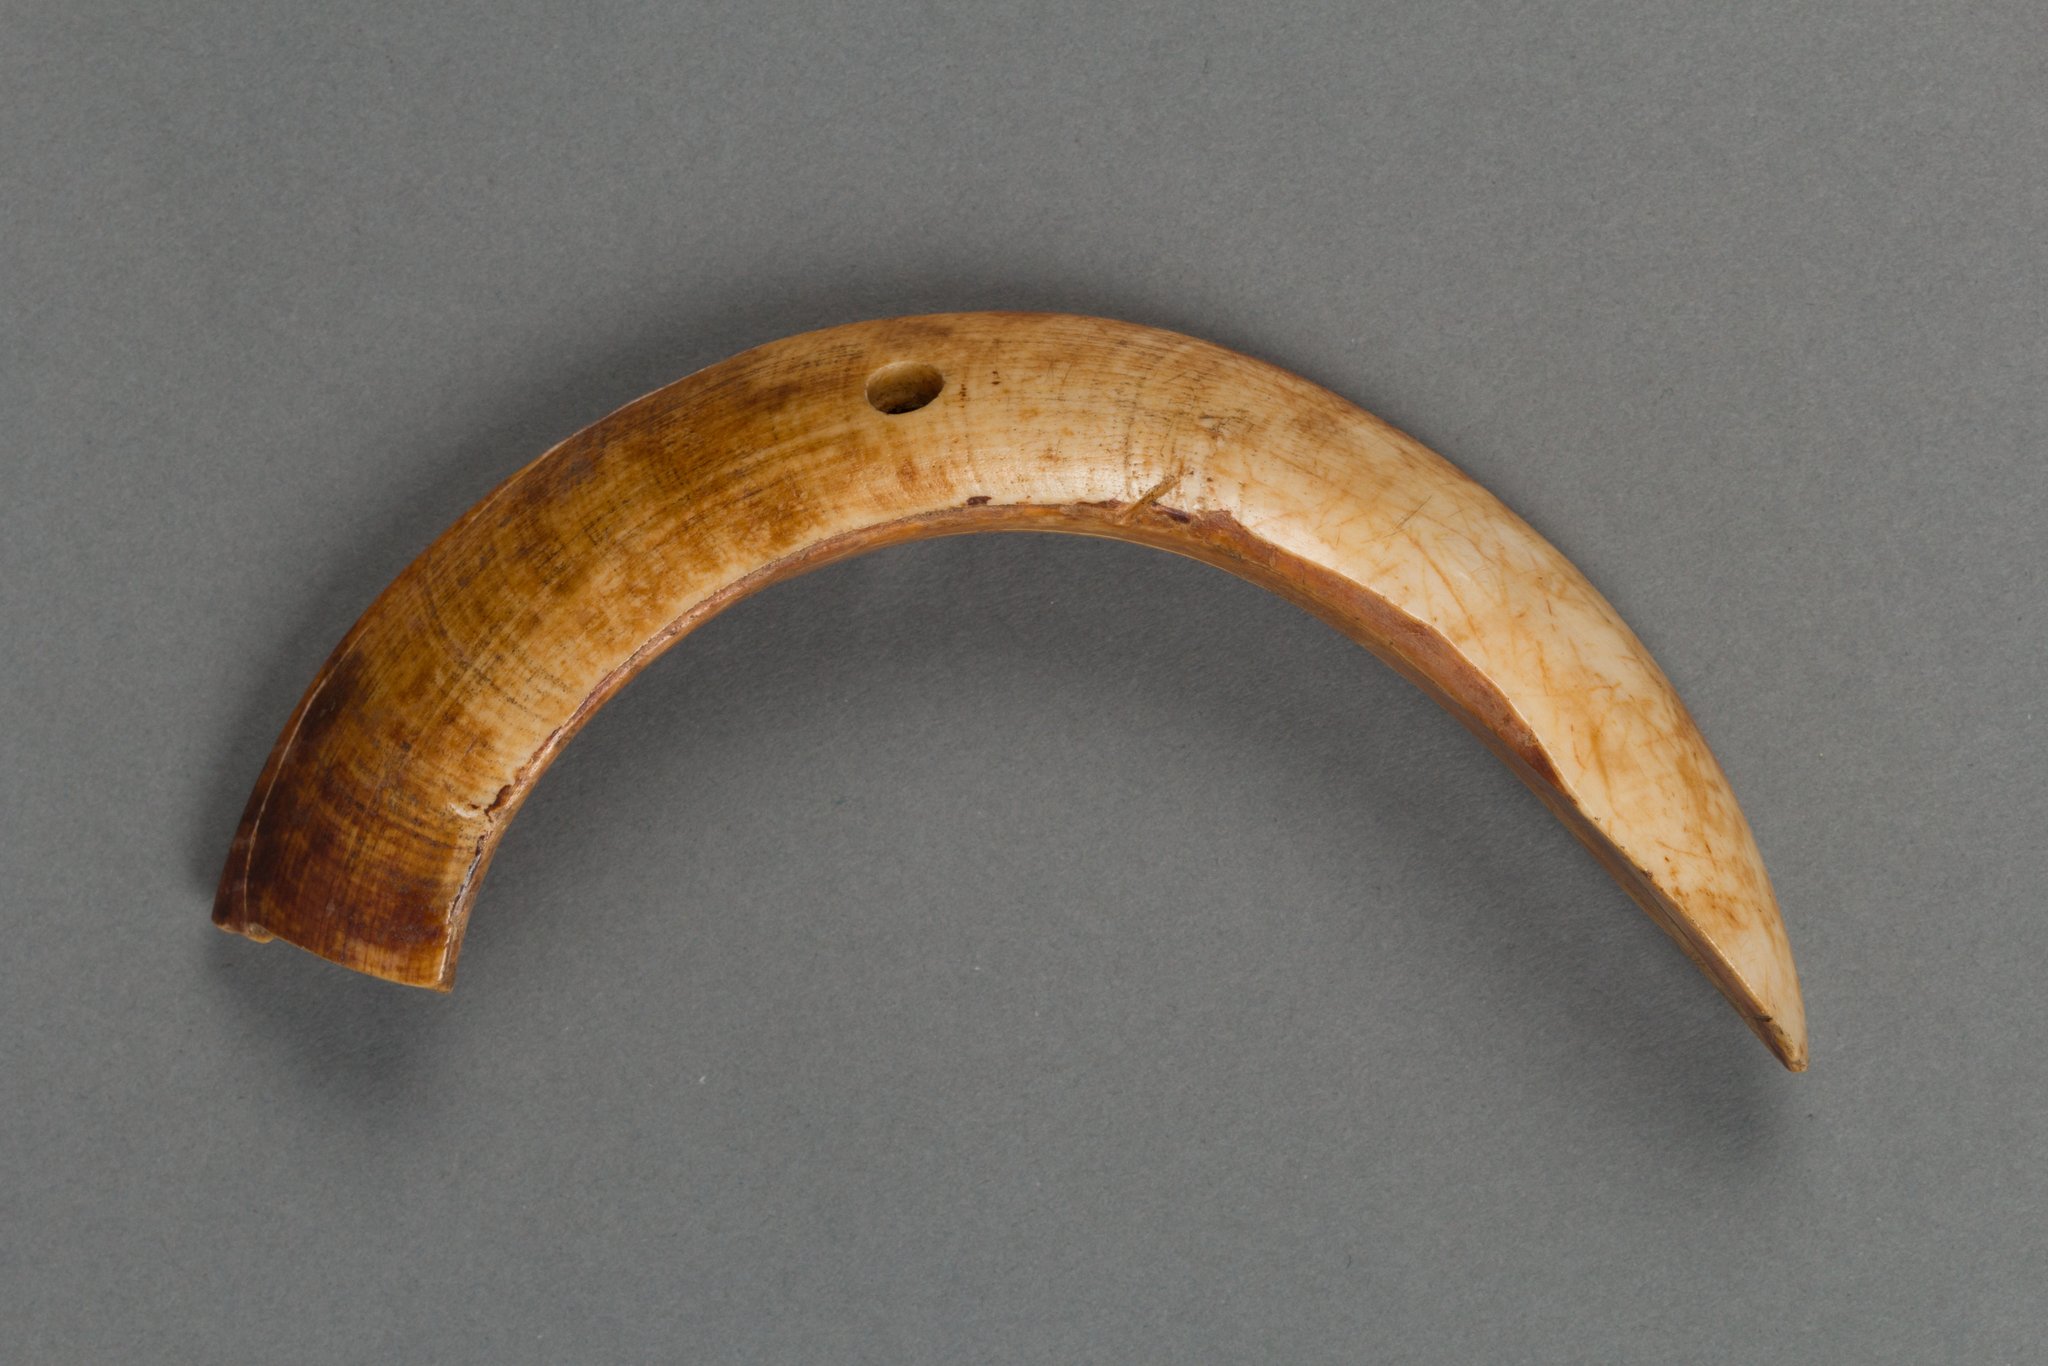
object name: body ornament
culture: japanese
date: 1200-200 BCE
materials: bone